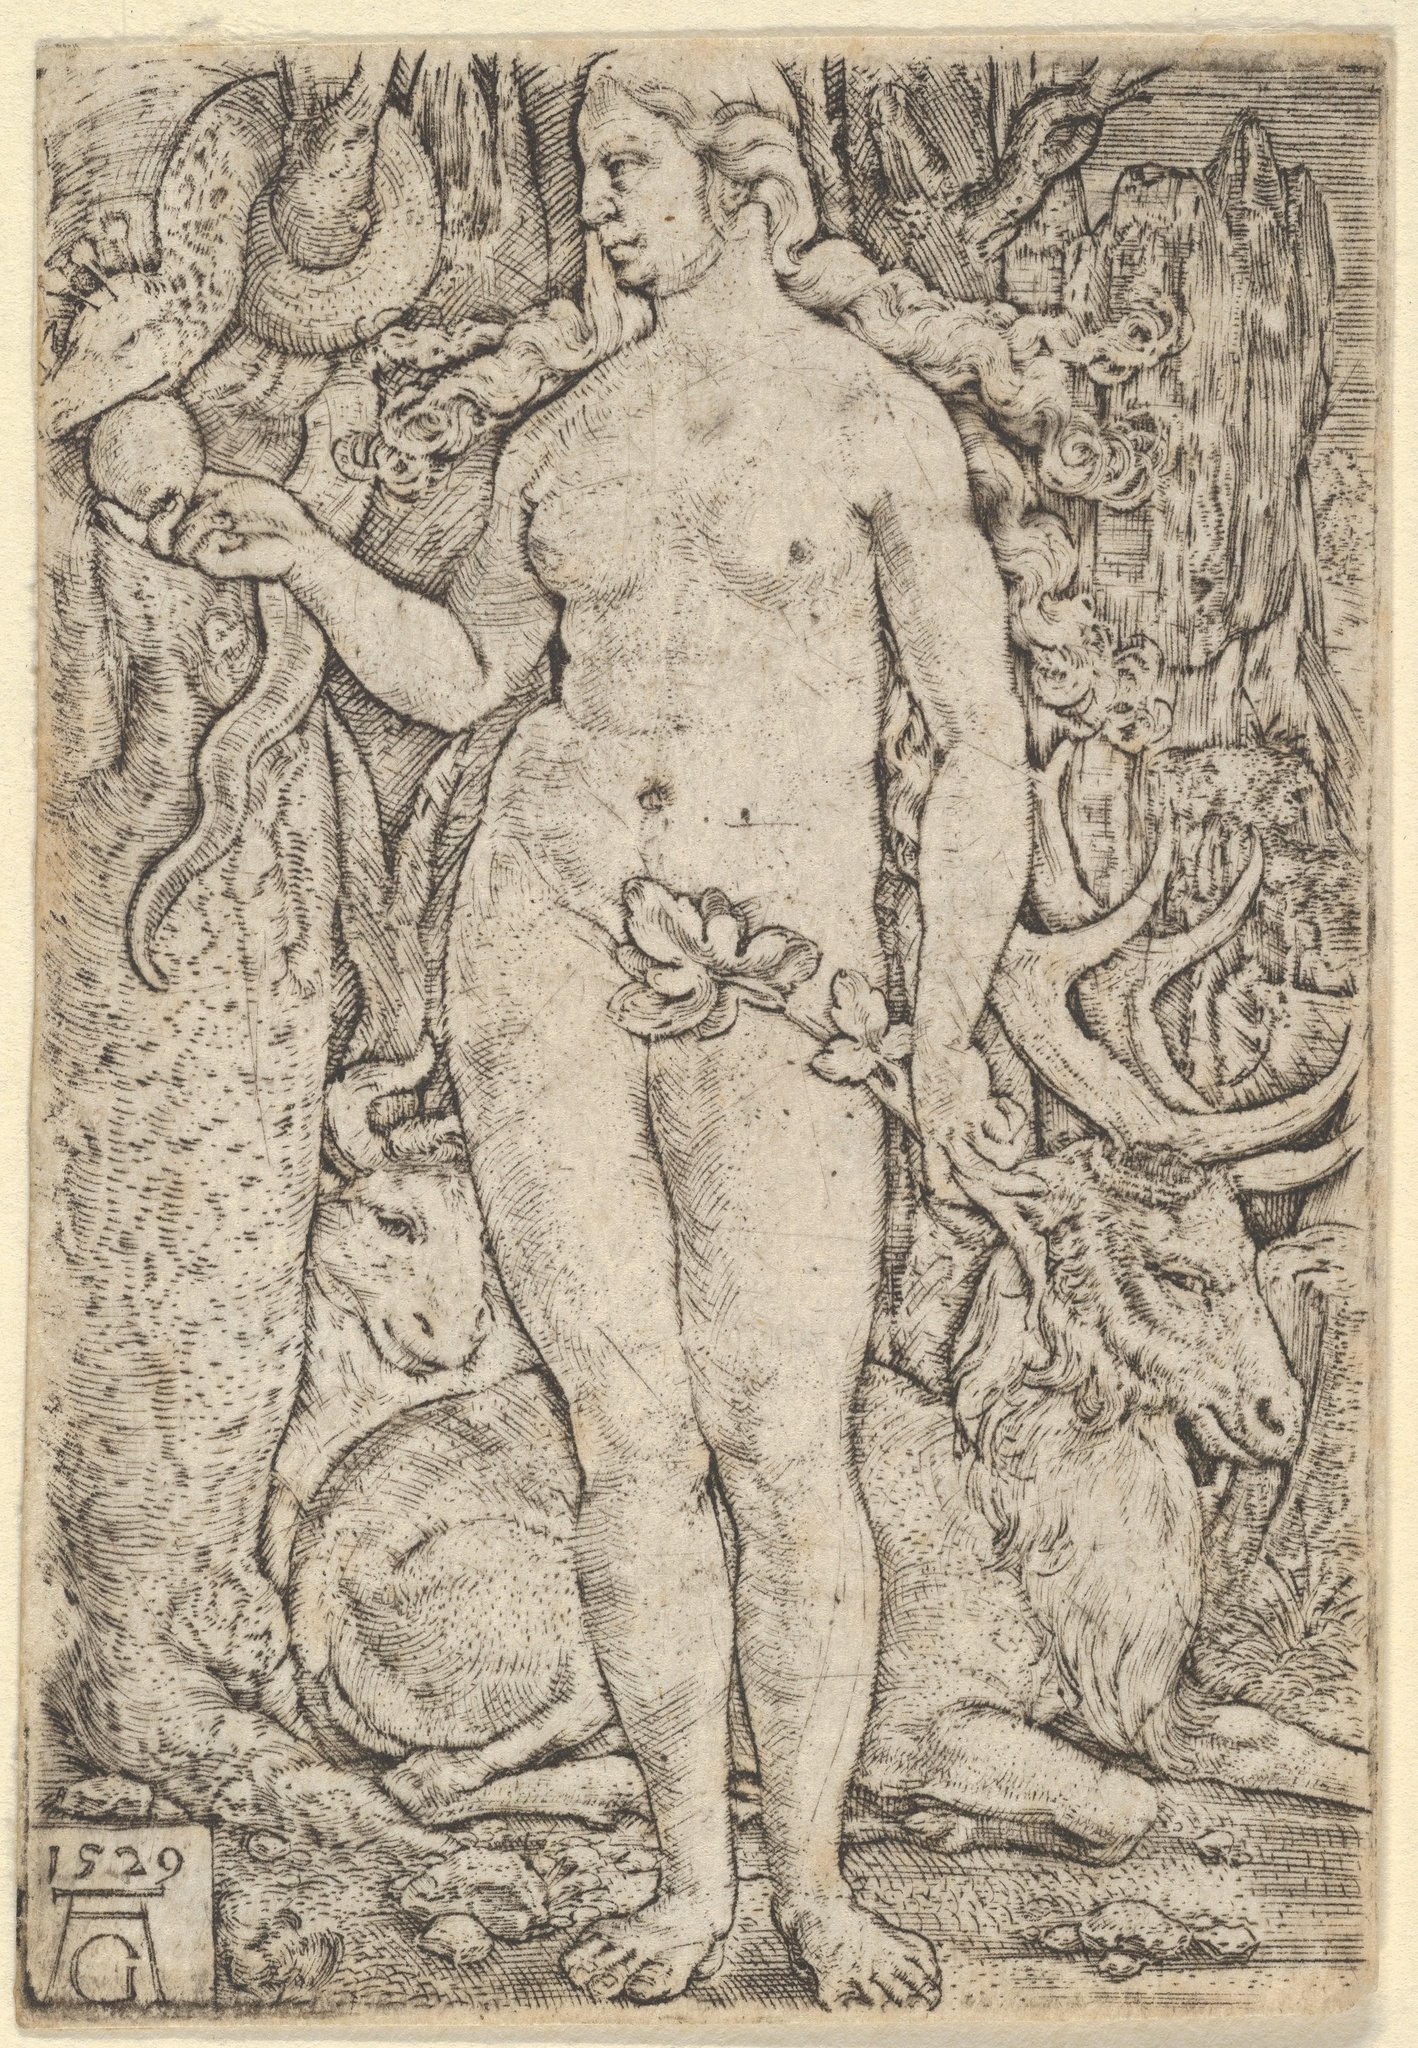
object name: print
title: Eve with a Stag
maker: heinrich aldegrever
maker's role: artist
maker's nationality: german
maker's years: 1502-1561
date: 1529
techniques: engraving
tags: deer,serpents,eve